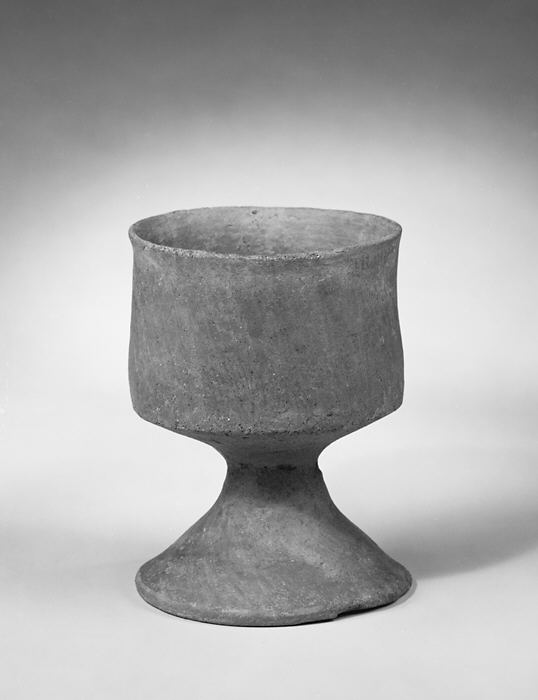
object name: stem cup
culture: japanese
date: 100-300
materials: earthenware